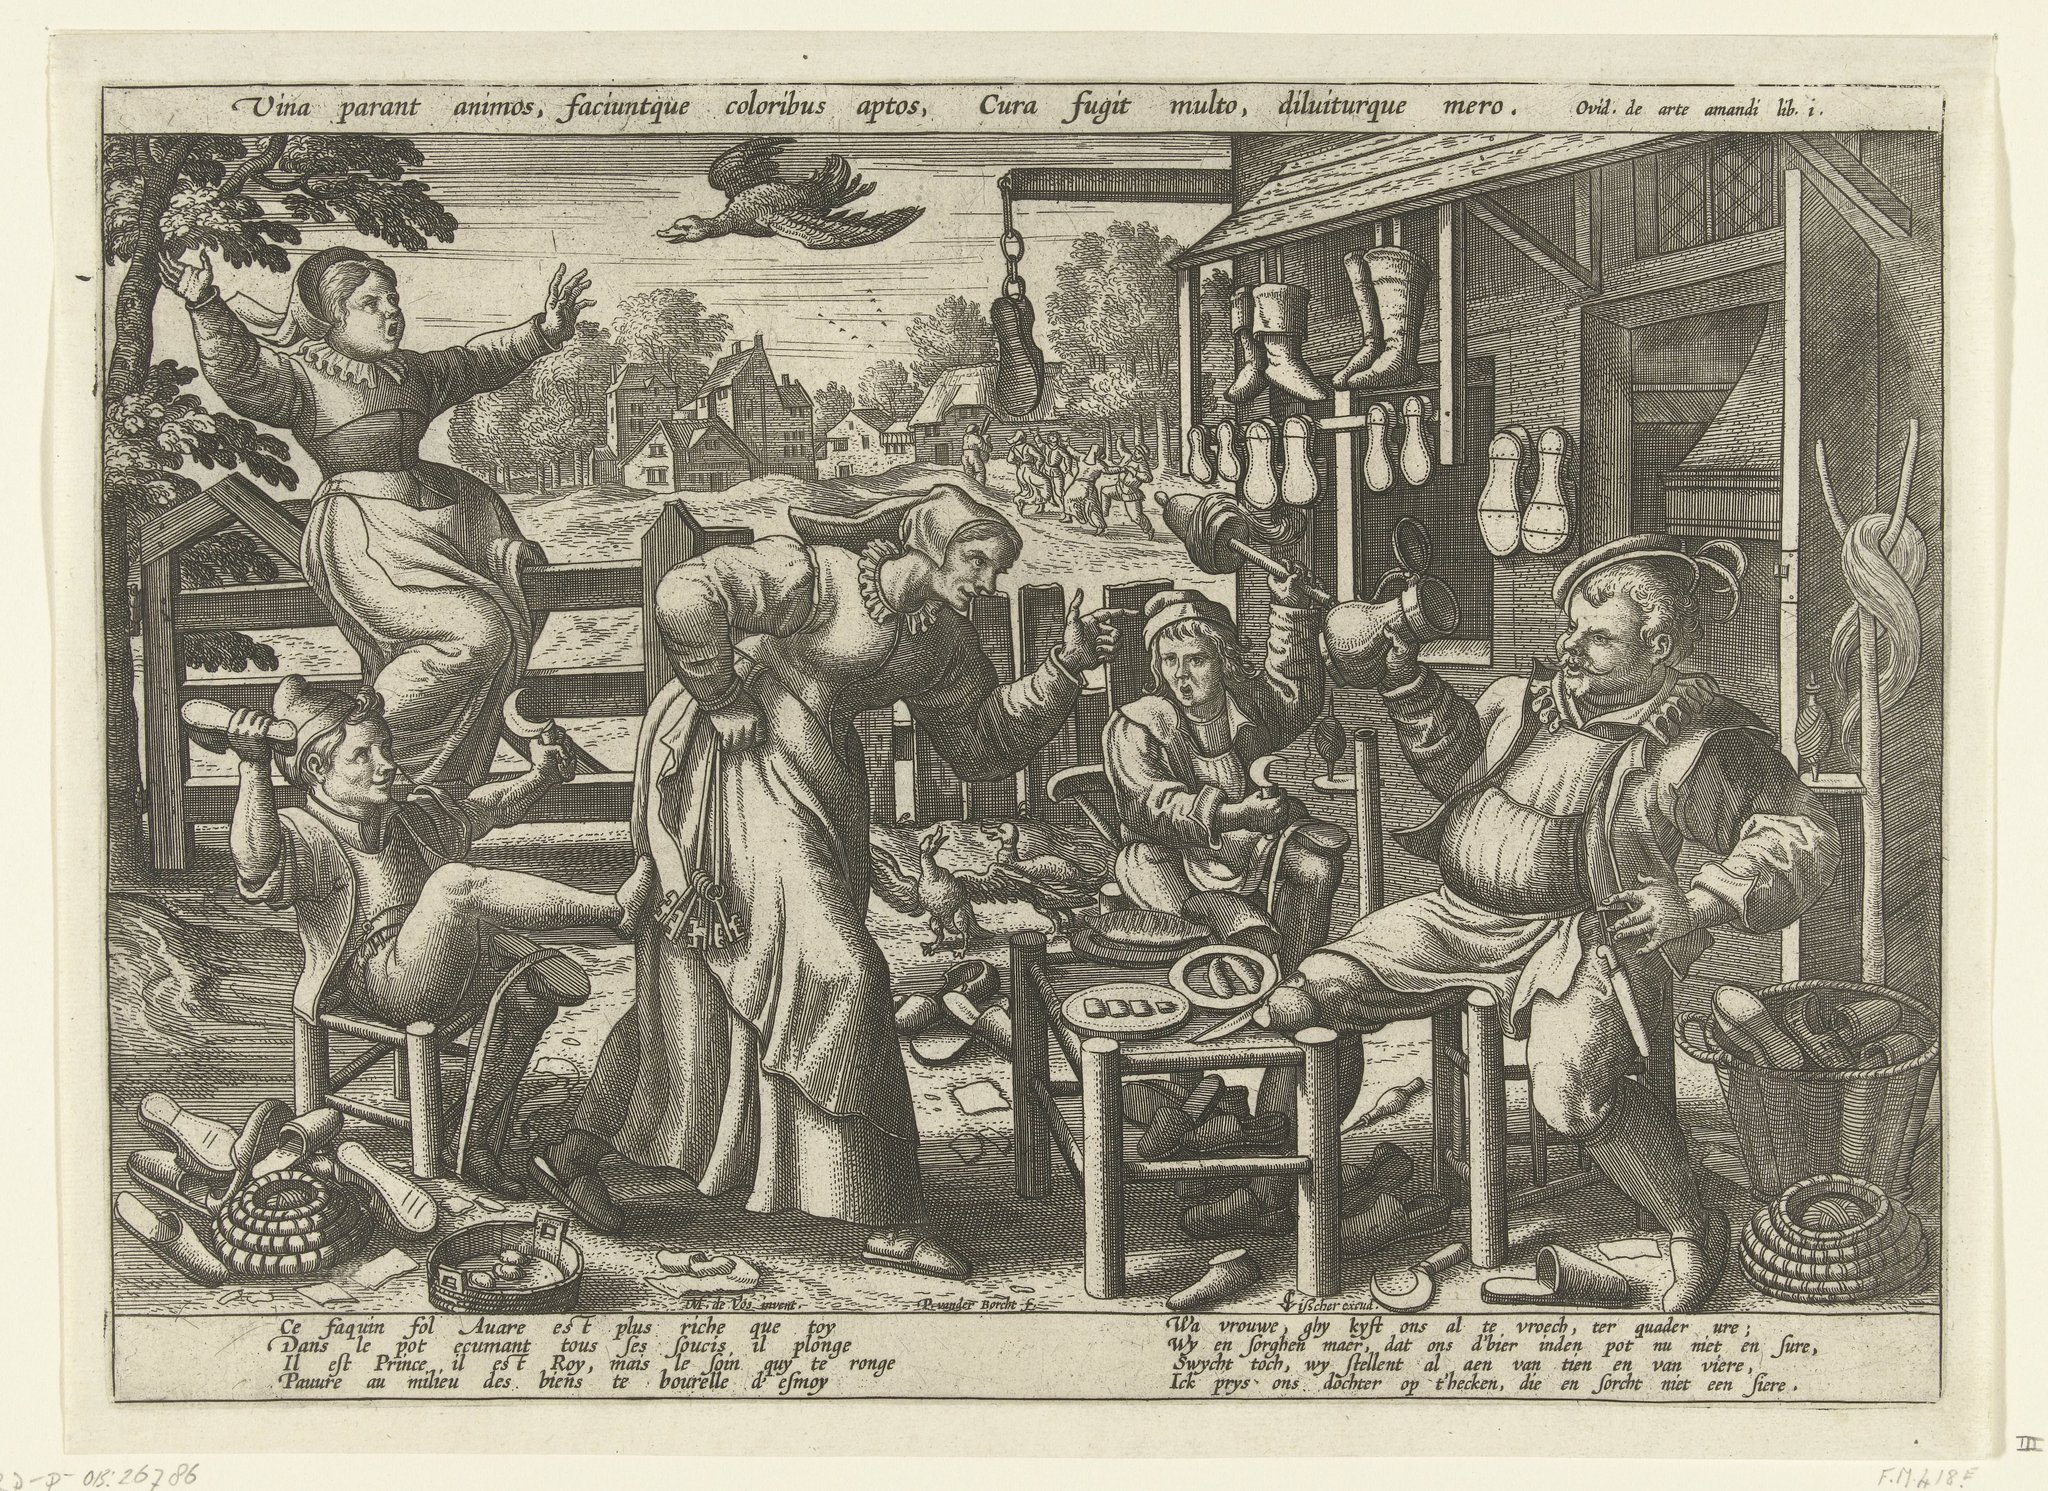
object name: print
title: Het bedorven huishouden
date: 1545-1608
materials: paper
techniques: engraving, etching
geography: amsterdam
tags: more than one couple dancing, man and wife quarrelling, 'marriage à la mode', shoe-maker, cobbler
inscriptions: caption: ‘Ce faquin fol Avare ets plus riche que toy...Pauvre au milieu des biens te bourelle d'esmoy.’, inscription: ‘Vina parant animos...dilviturque mero. Ovid. de arte amandi lib. i’ Ovidius, address: ‘Vischer excud.’, signature: ‘M. de Vos invent.’, signature: ‘P. vander Borcht f.’, collector's mark: 2228, caption: ‘Wa vrouwe, kyft ons al te vroech, ter quader ure...Ick prijs ons dochter op 't hecken, die en sorcht niet een siere.’ Lugt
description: Schoenmaker voor zijn huis, zittend voor zijn werkbank. In plaats van te werken drinkt hij een pint bier. Zijn leerjongens, die schoenen maken, schoppen keet. De vrouw van de schoenmaker staat kijvend voor hem. Zijn dochter zit al roepend op een hek. Op de achtergrond dansen boeren op de muziek van een doedelzak. Met bovenschrift van een regel in het Latijn en onderschrift van 2 kolommen van elk 4 regels in het Frans en Nederlands.